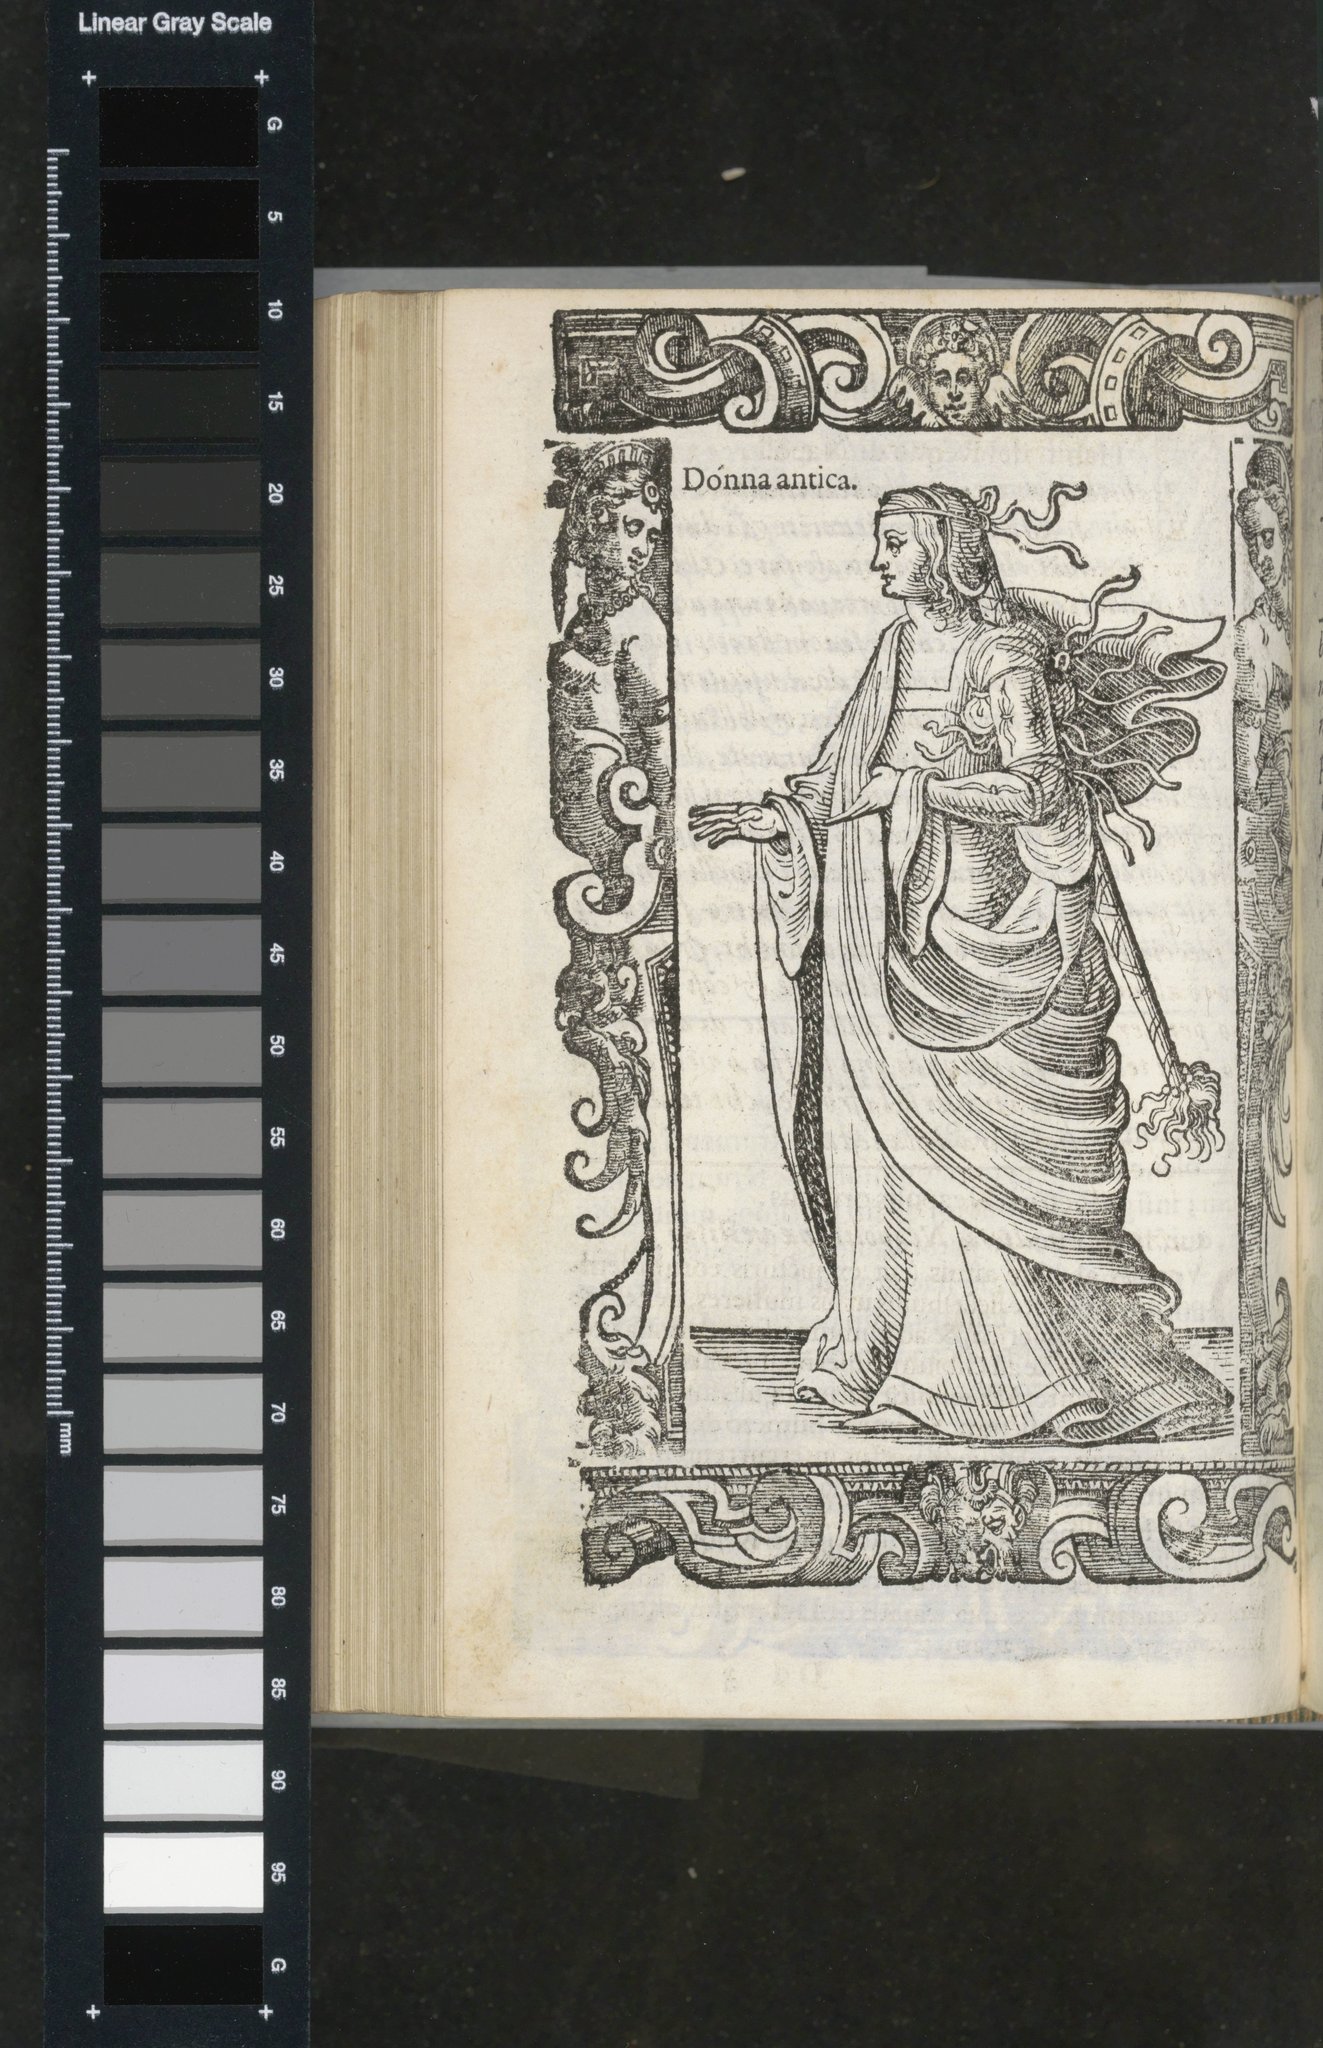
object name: costume print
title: Donna antica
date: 1598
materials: paper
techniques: woodcut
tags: fashion plates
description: Spiegelbeeldig en ander kleed; zelfde houding